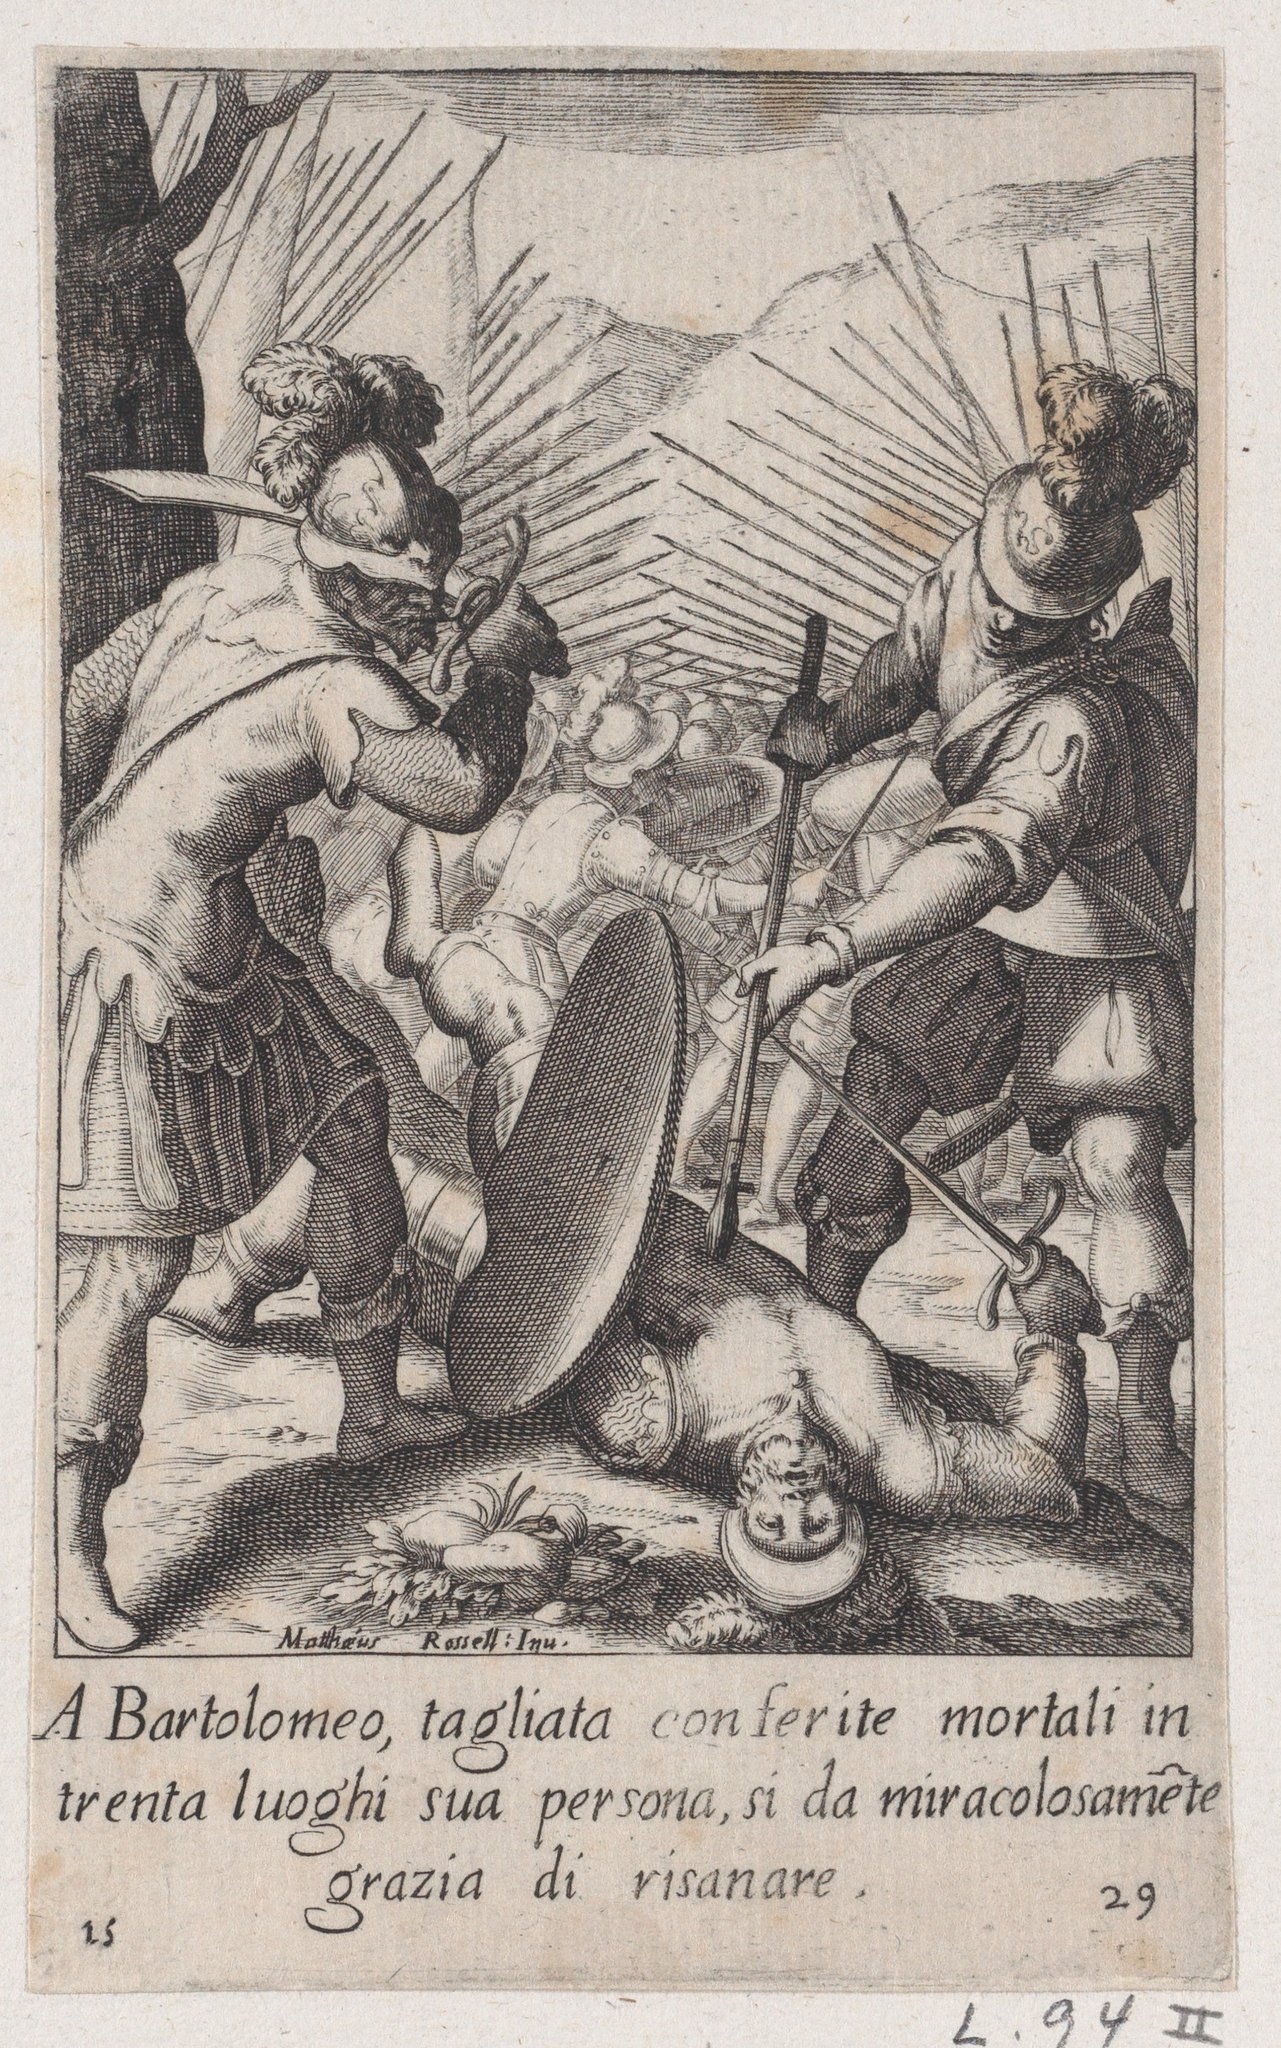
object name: print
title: Bartolomeo, from Scelta d'Alcuni Miracoli e Grazie della Santissima Nunziata di Firenze (Selection of Some Miracles and Graces that Occurred in the Church of the Annunziata in Florence)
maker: jacques callot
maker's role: artist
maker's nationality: french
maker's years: 1592-1635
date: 1611-1619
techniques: engraving